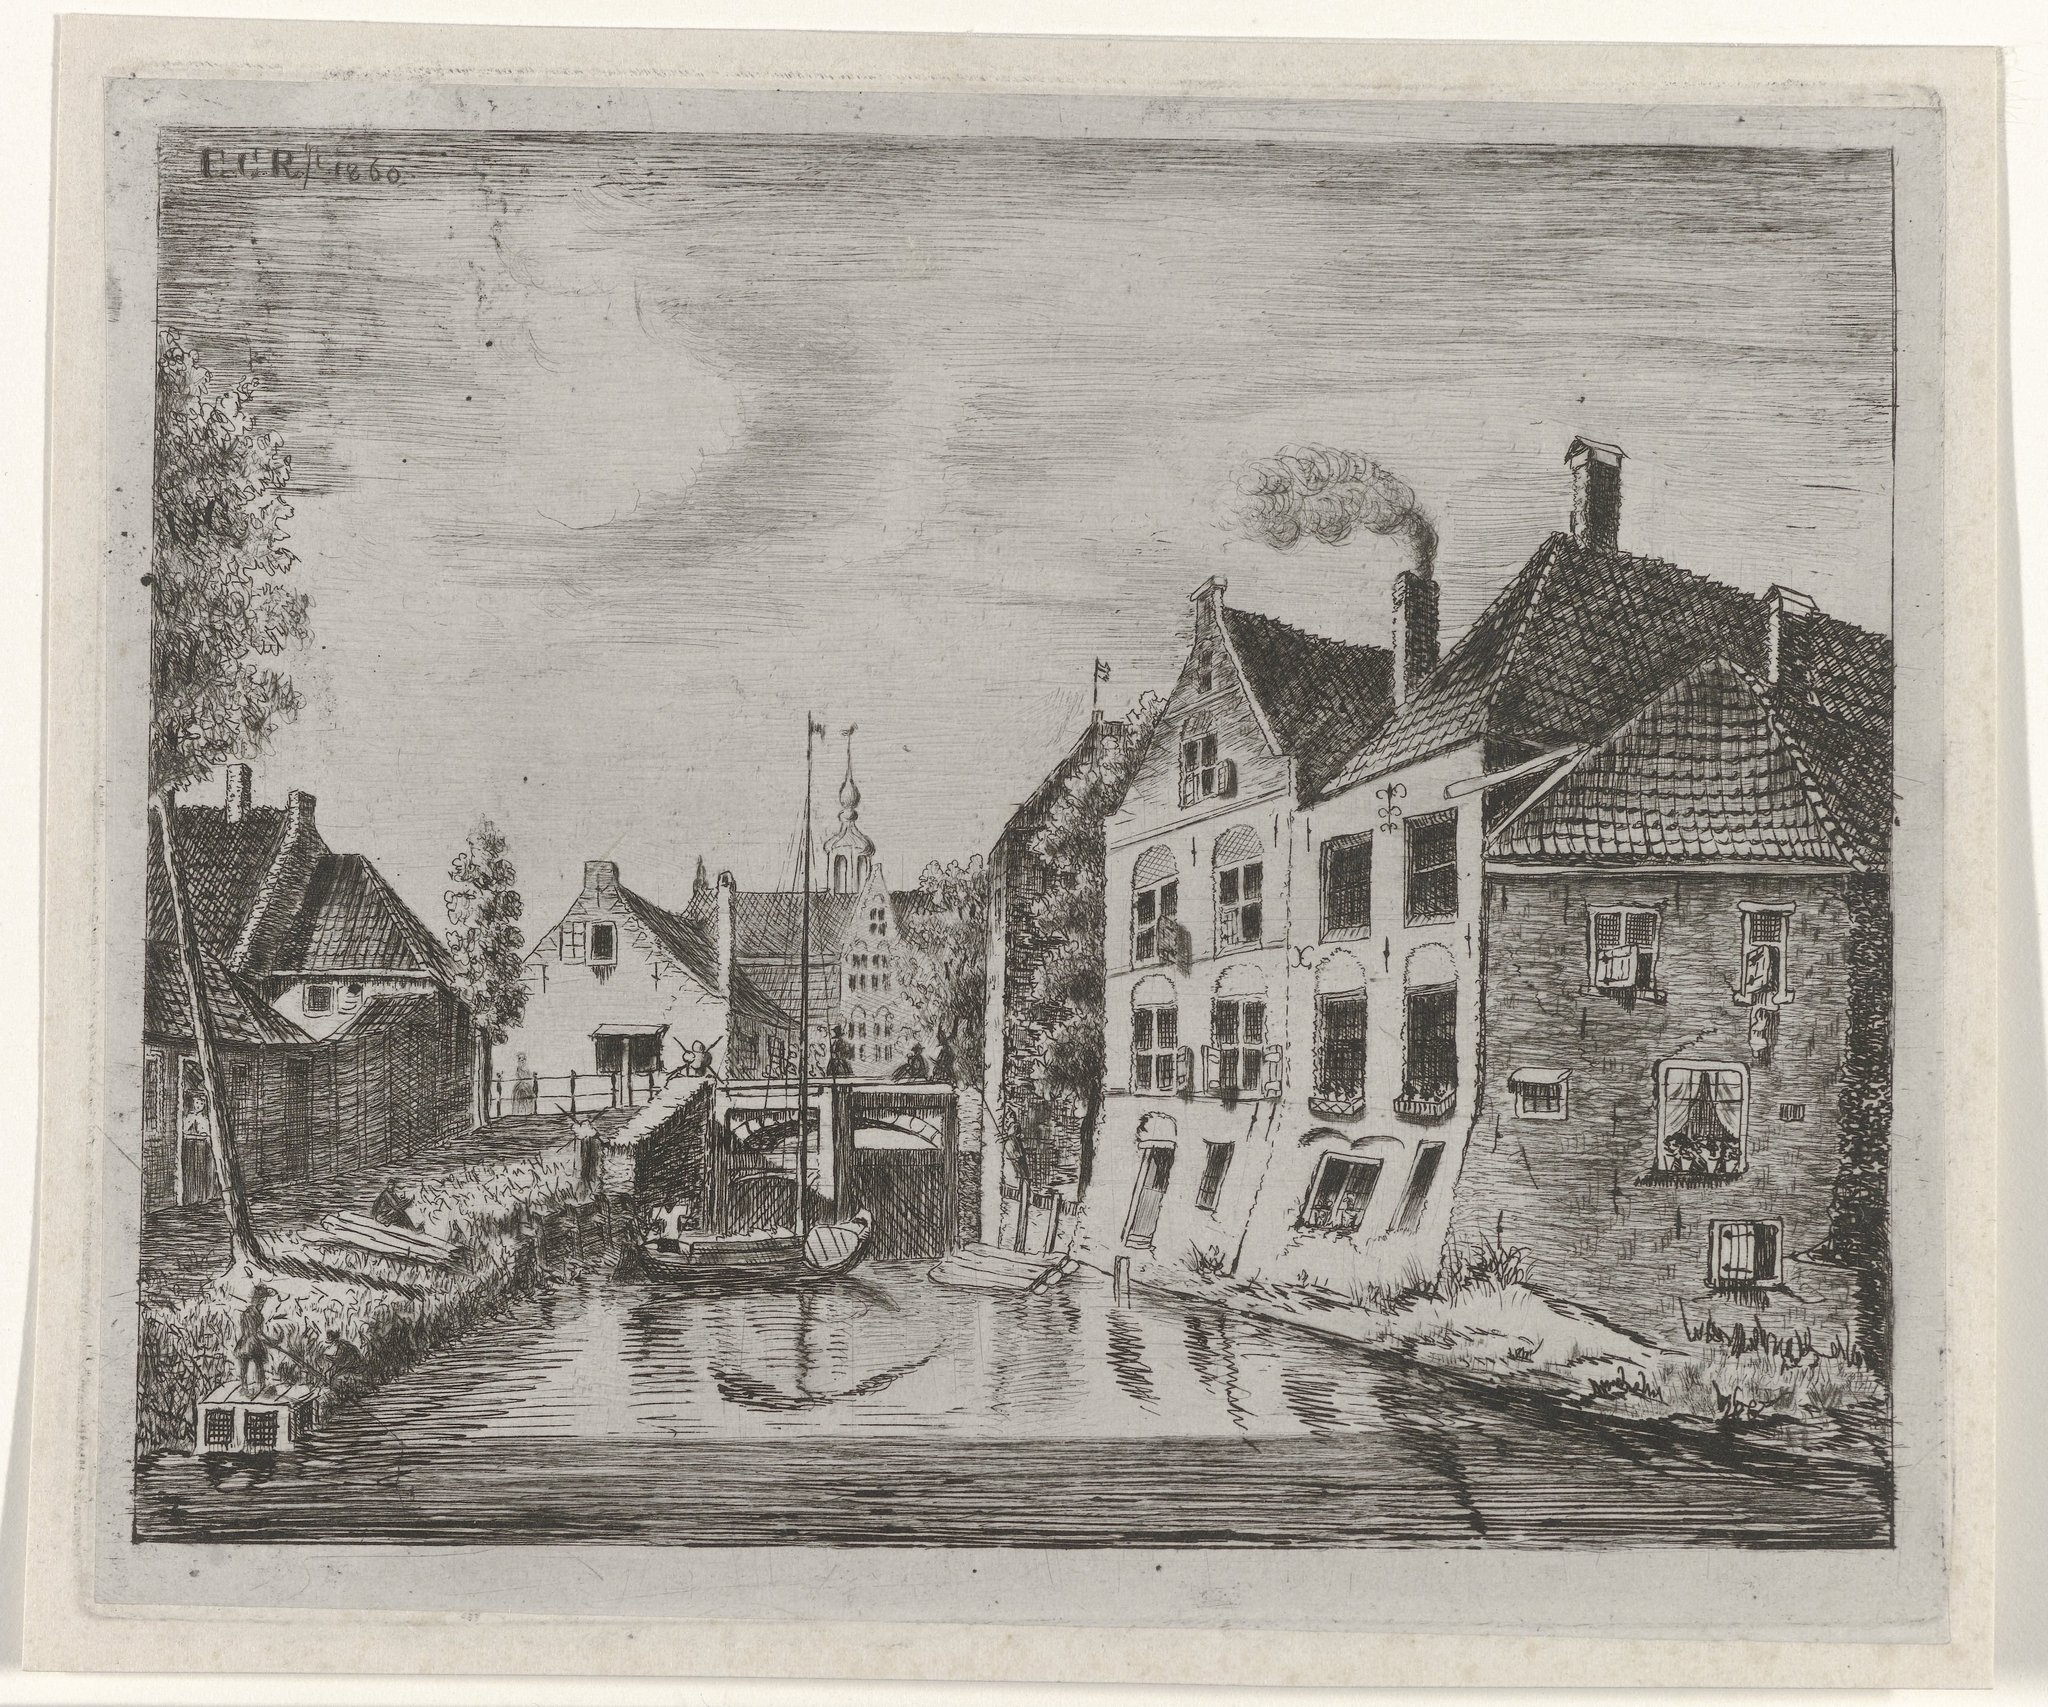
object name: print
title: Gevangentoren te Oudewater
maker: eberhard cornelis rahms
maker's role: print maker, publisher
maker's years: 1823-1907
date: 1860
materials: paper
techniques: etching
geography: oudewater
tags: sailing-ship, sailing-boat, canal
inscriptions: collector's mark: Lugt 2228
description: Gezicht op de Gevangentoren en de Romeinsebrug te Oudewater. Op de voorgrond een gracht waar een zeilbootje op ligt.